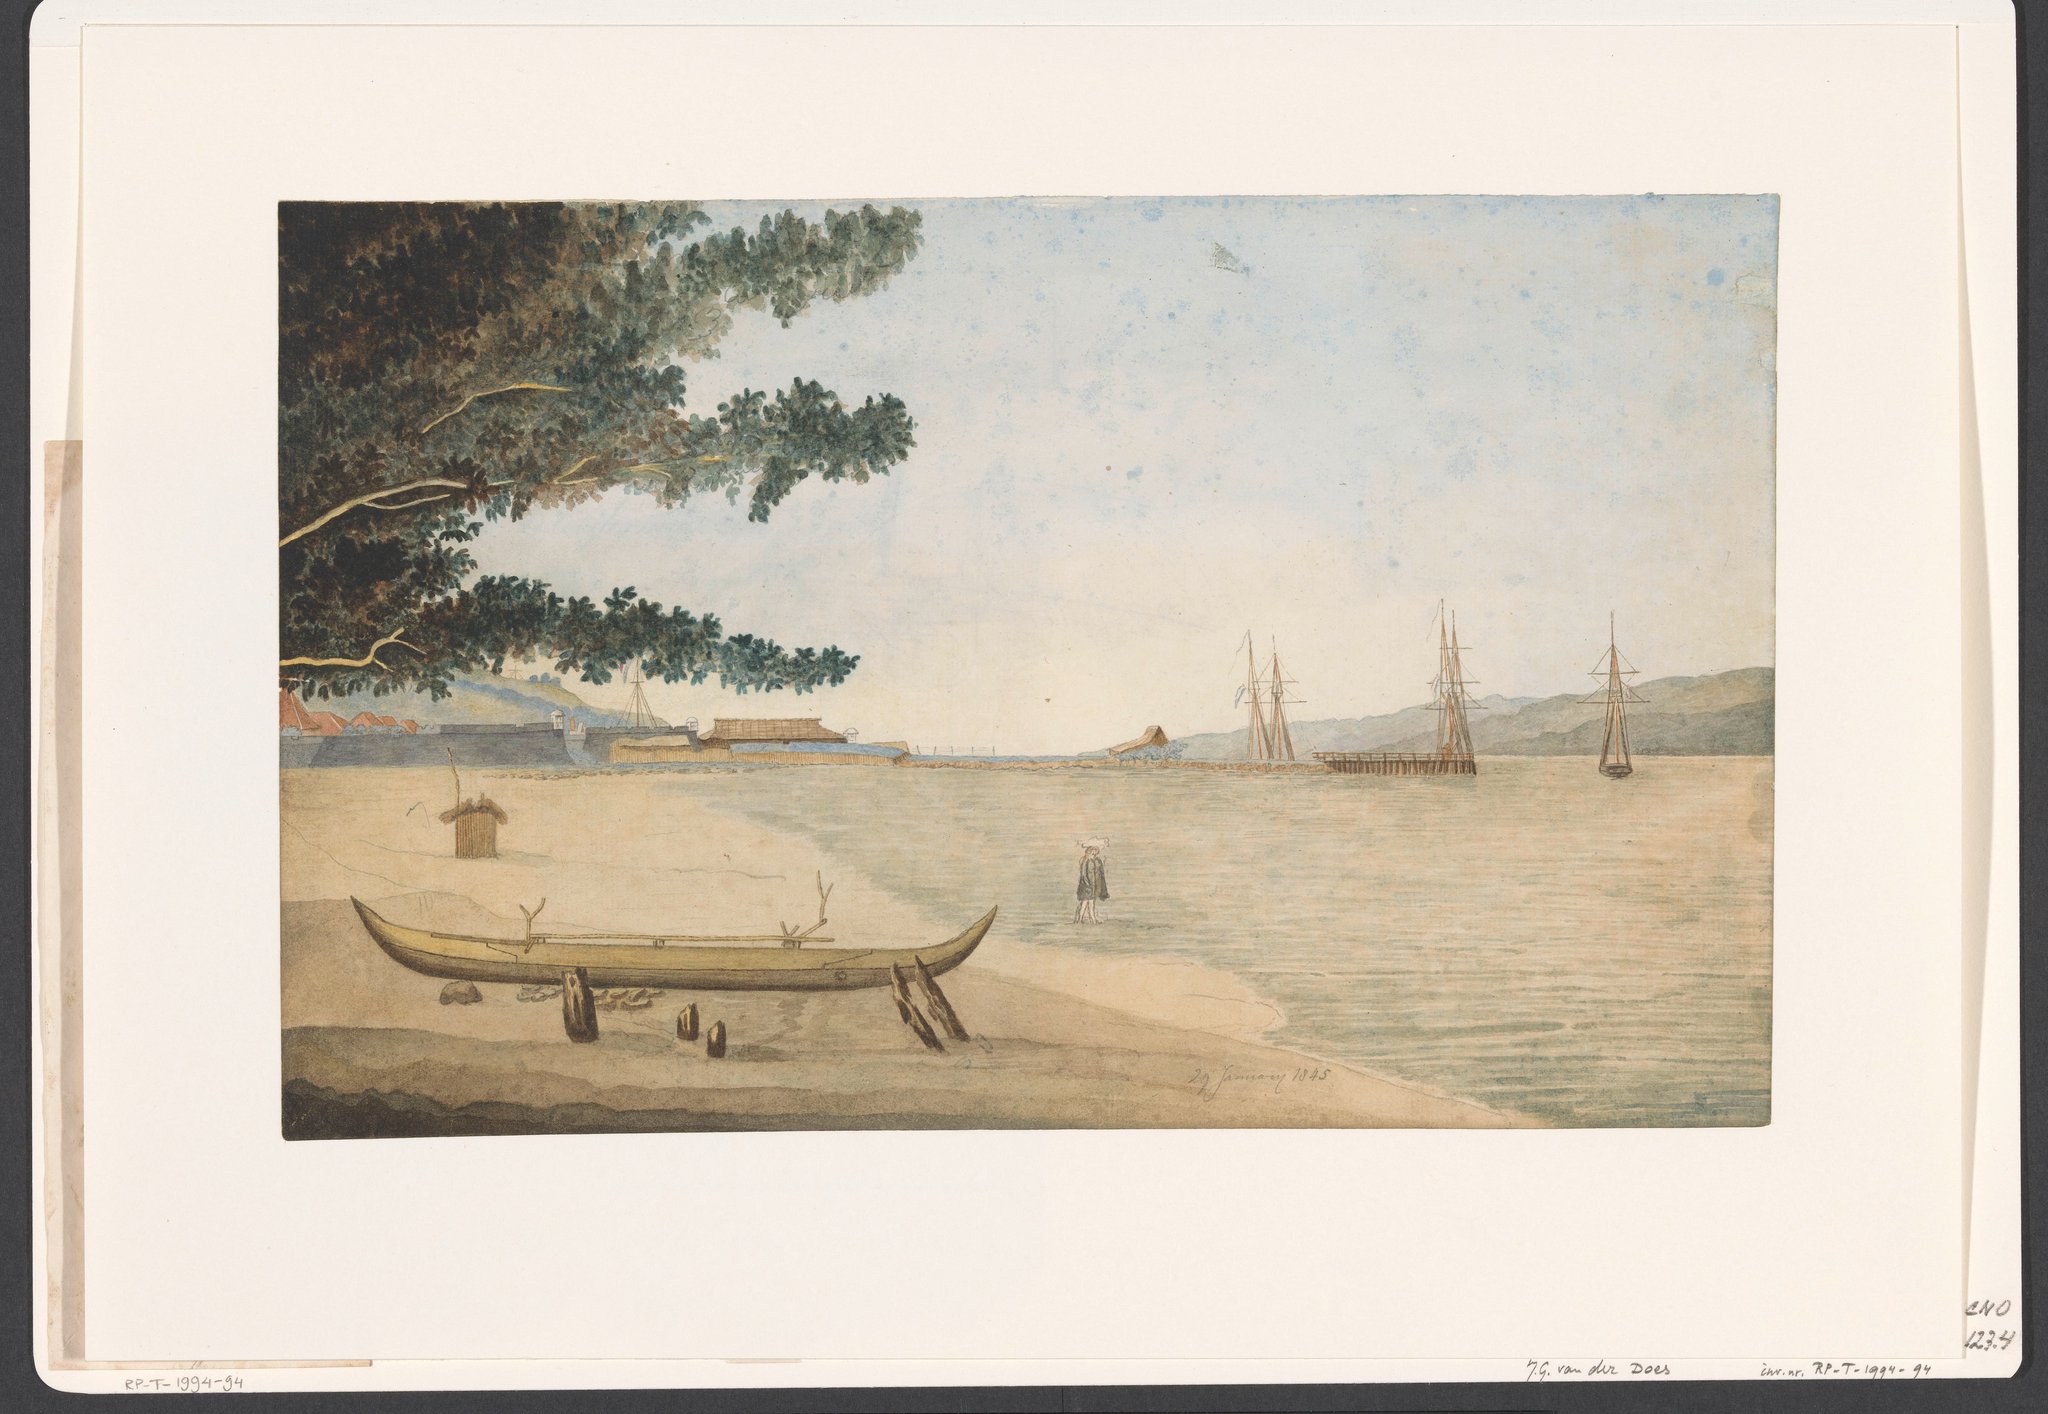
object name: drawing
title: Gezicht op een Nederlandse nederzetting met fort en haven in Indonesië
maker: j. g. van der does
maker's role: draughtsman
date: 1845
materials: ink, paper, pencil, watercolor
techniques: brush, pen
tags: harbour, sailing-ship, sailing-boat, coast, indonesia